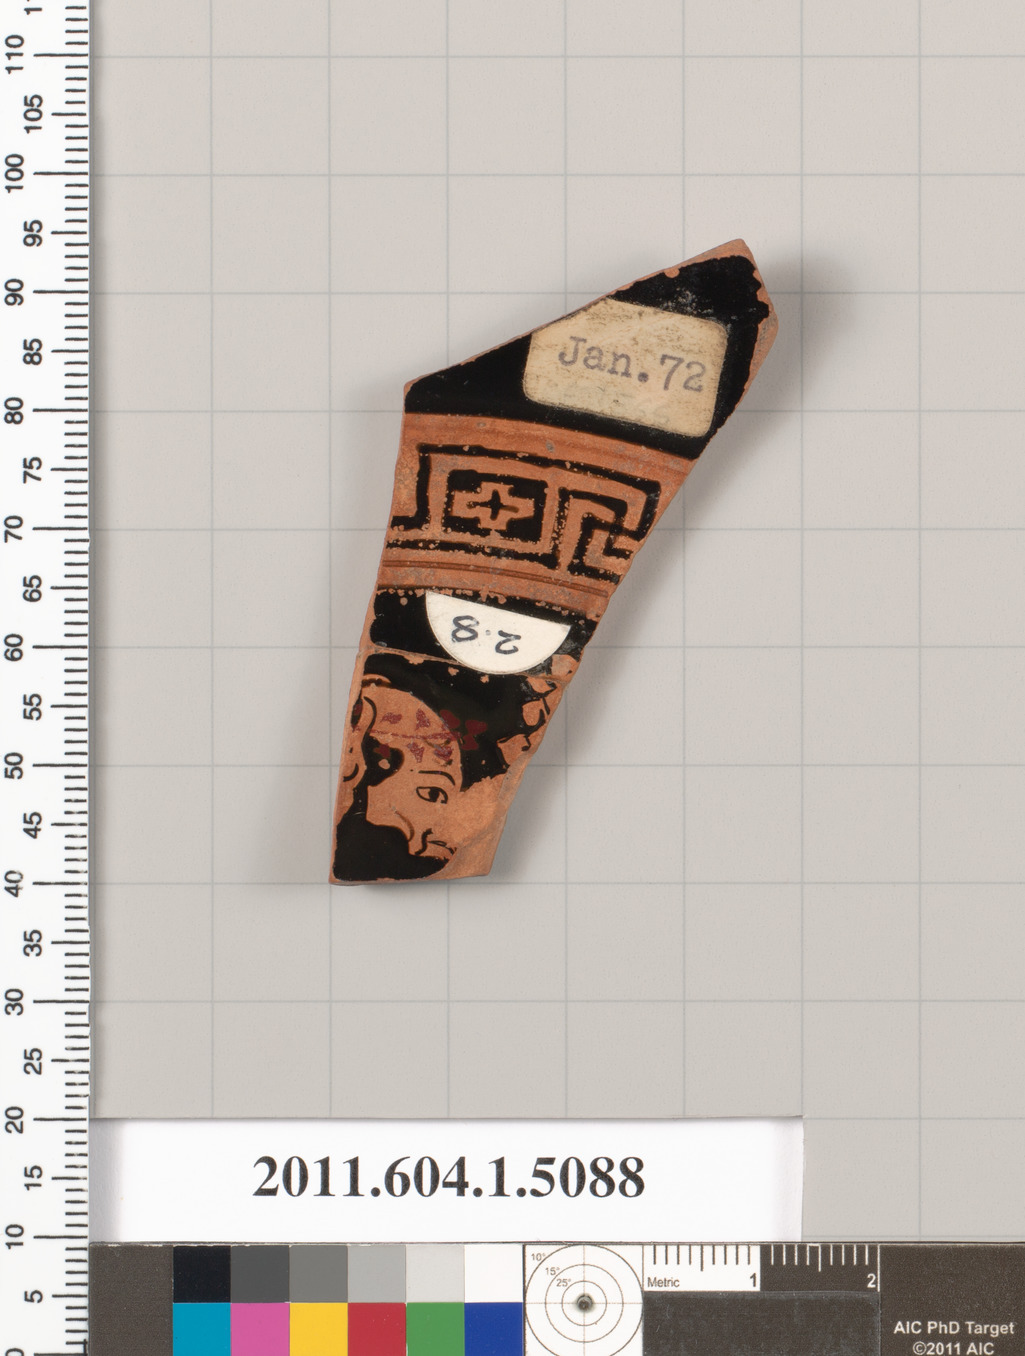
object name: kylix fragment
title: Terracotta fragment of a kylix (drinking cup)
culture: greek, attic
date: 510-490 BCE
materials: terracotta